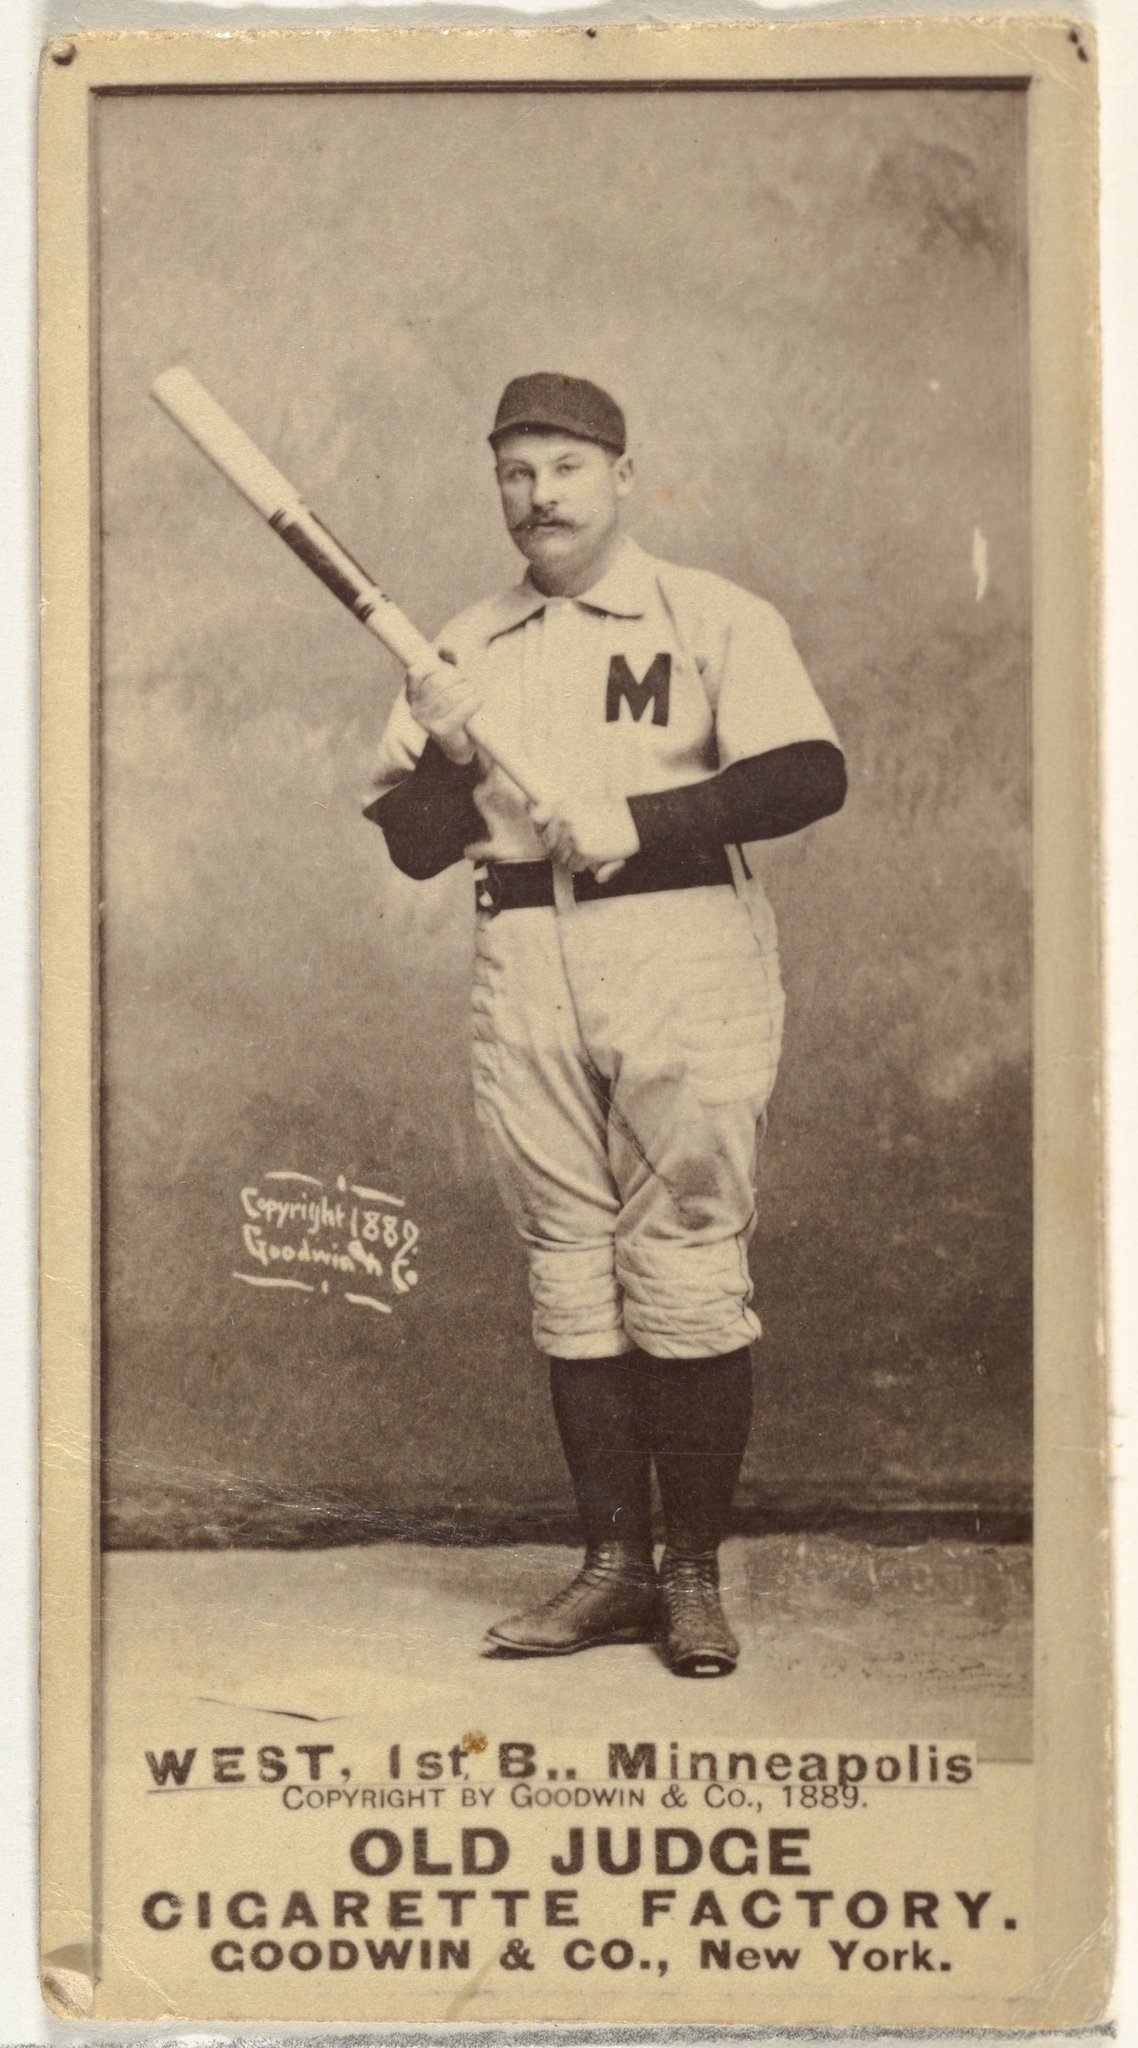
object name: baseball card, photograph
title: Milton Douglas "Buck" West, 1st Base, Minneapolis, from the Old Judge series (N172) for Old Judge Cigarettes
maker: goodwin & company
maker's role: publisher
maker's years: 1850-1950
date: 1889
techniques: albumen silver print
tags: men,portraits,baseball,athletes